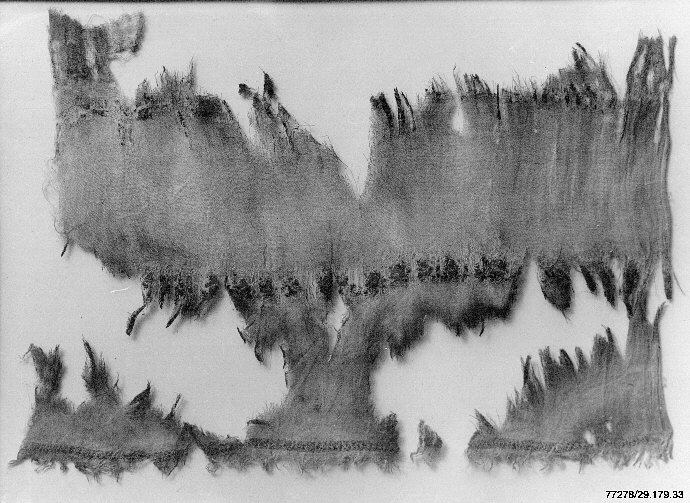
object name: textile fragment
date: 901-1000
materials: linen, silk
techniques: weave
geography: egypt